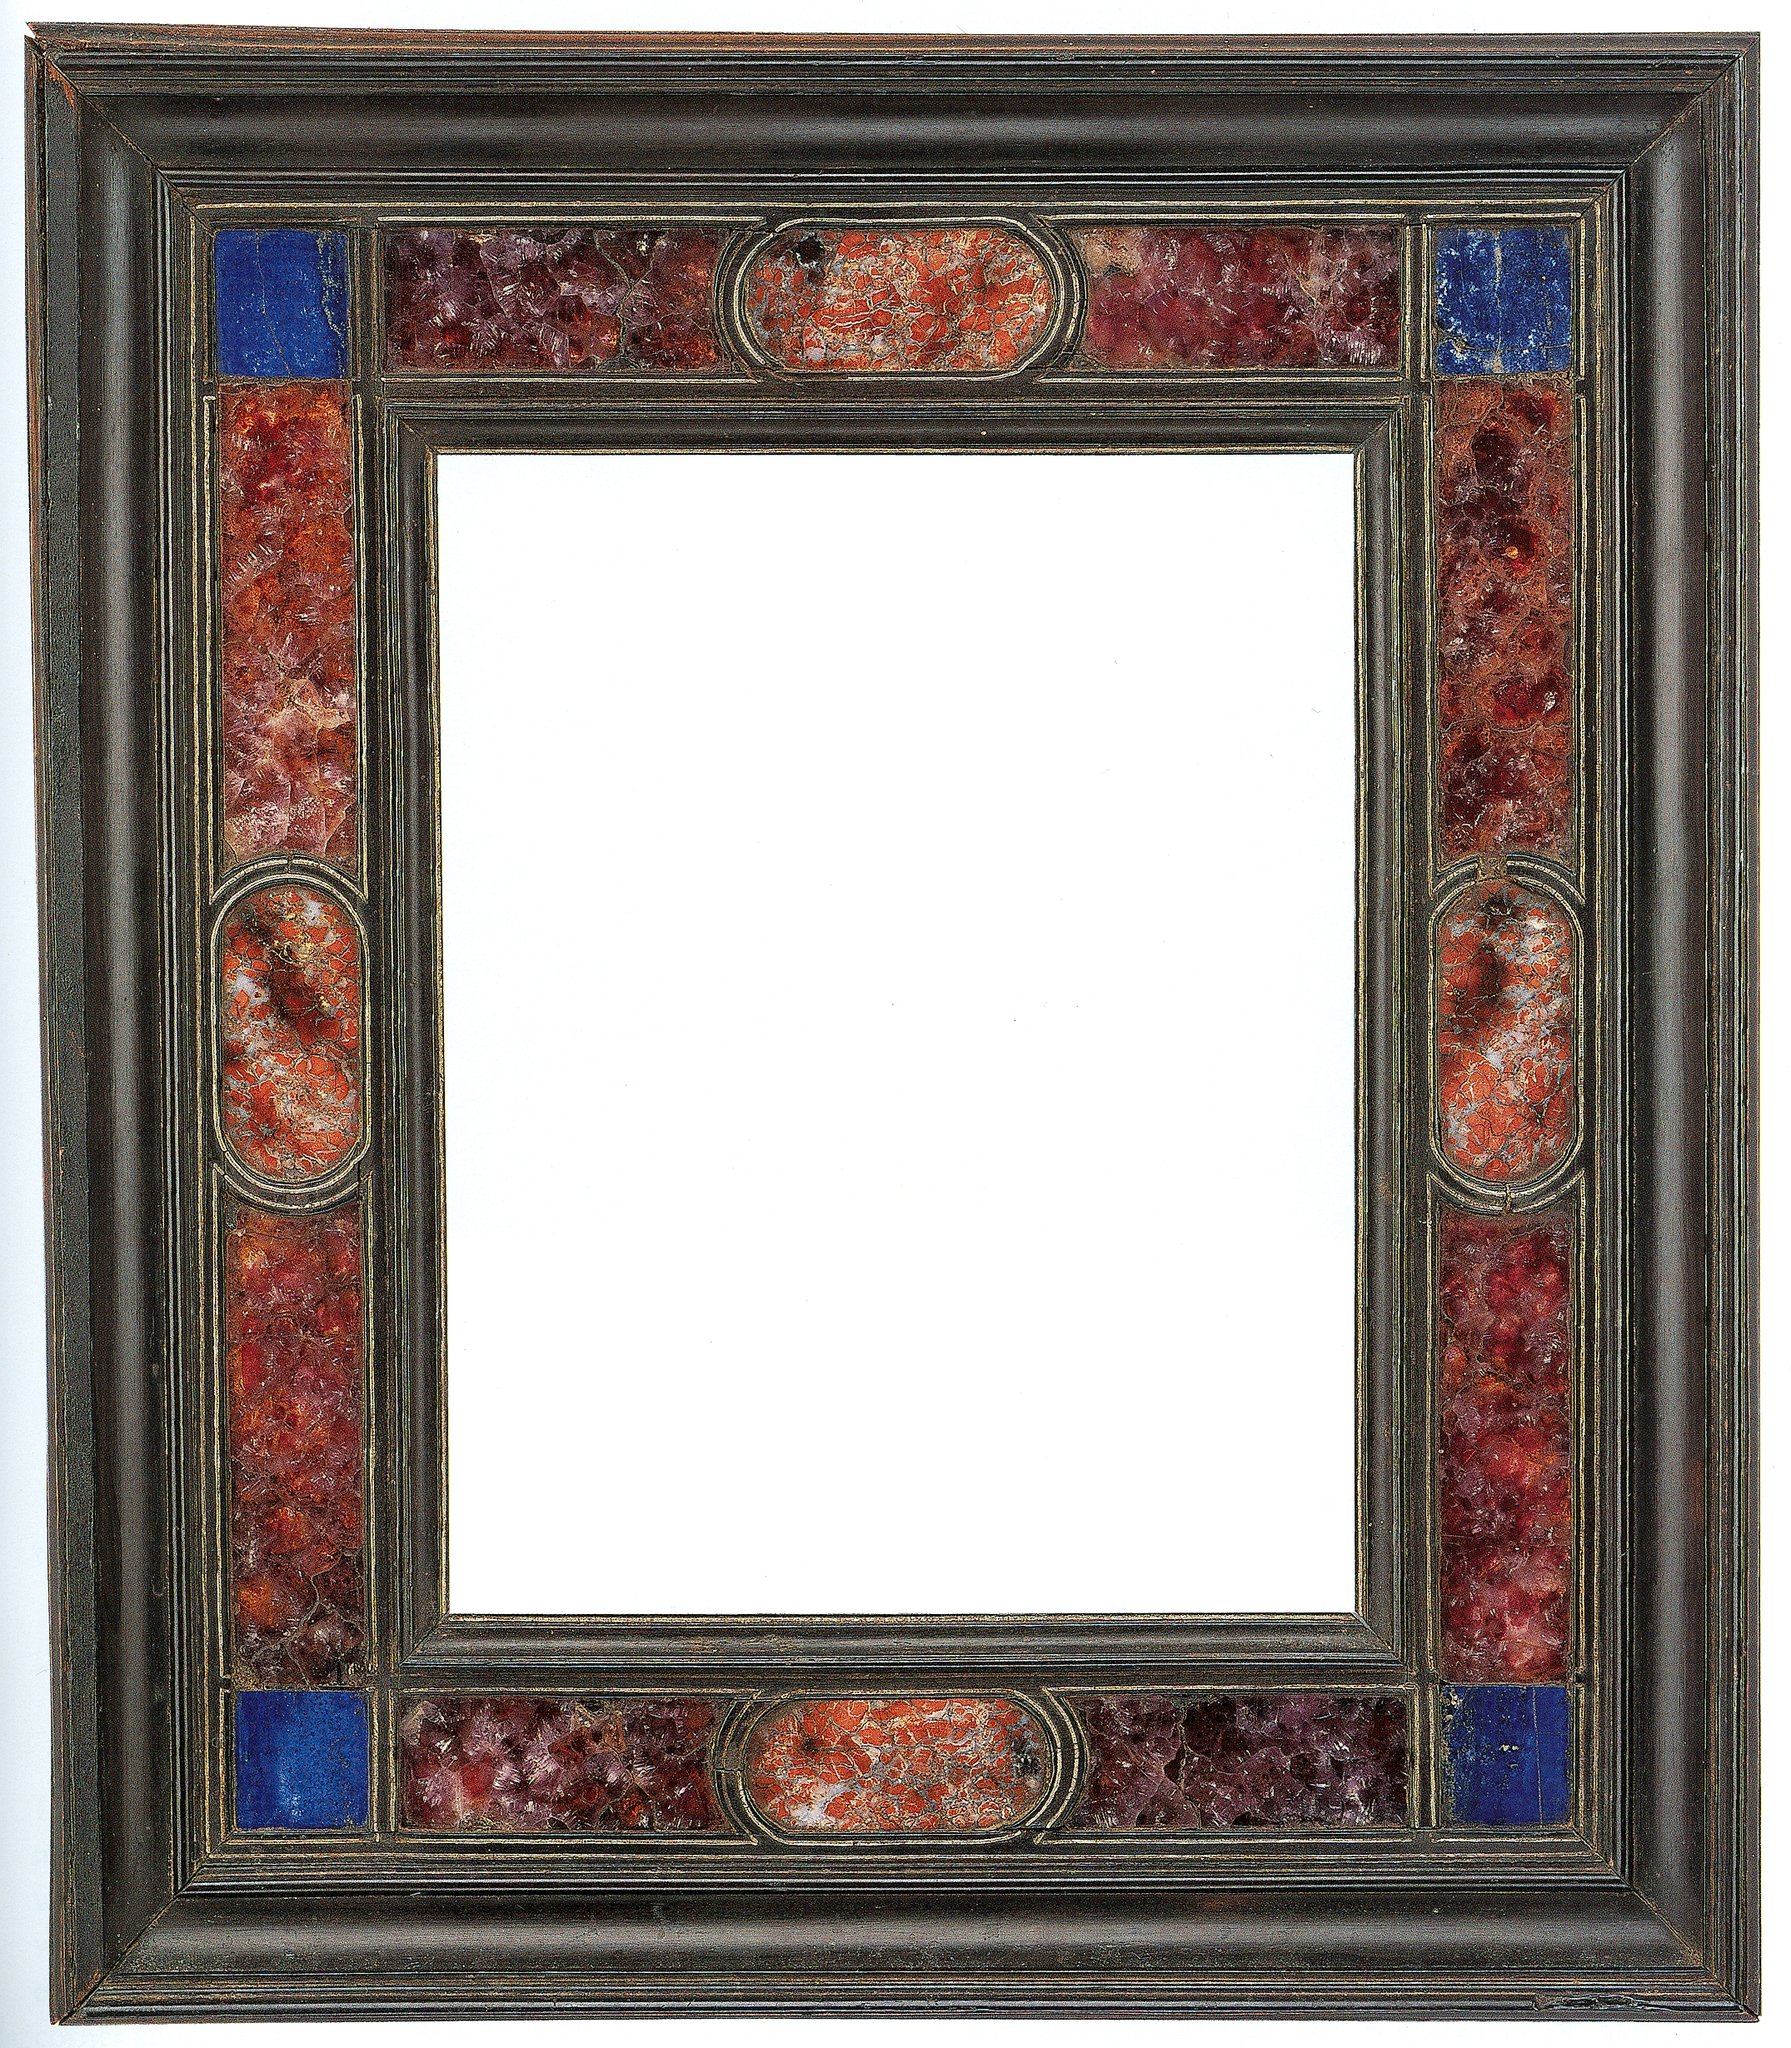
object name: frame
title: Cassetta frame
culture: italian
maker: Anonymous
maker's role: artist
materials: crystal, wood, glaze, niello, panel, silver